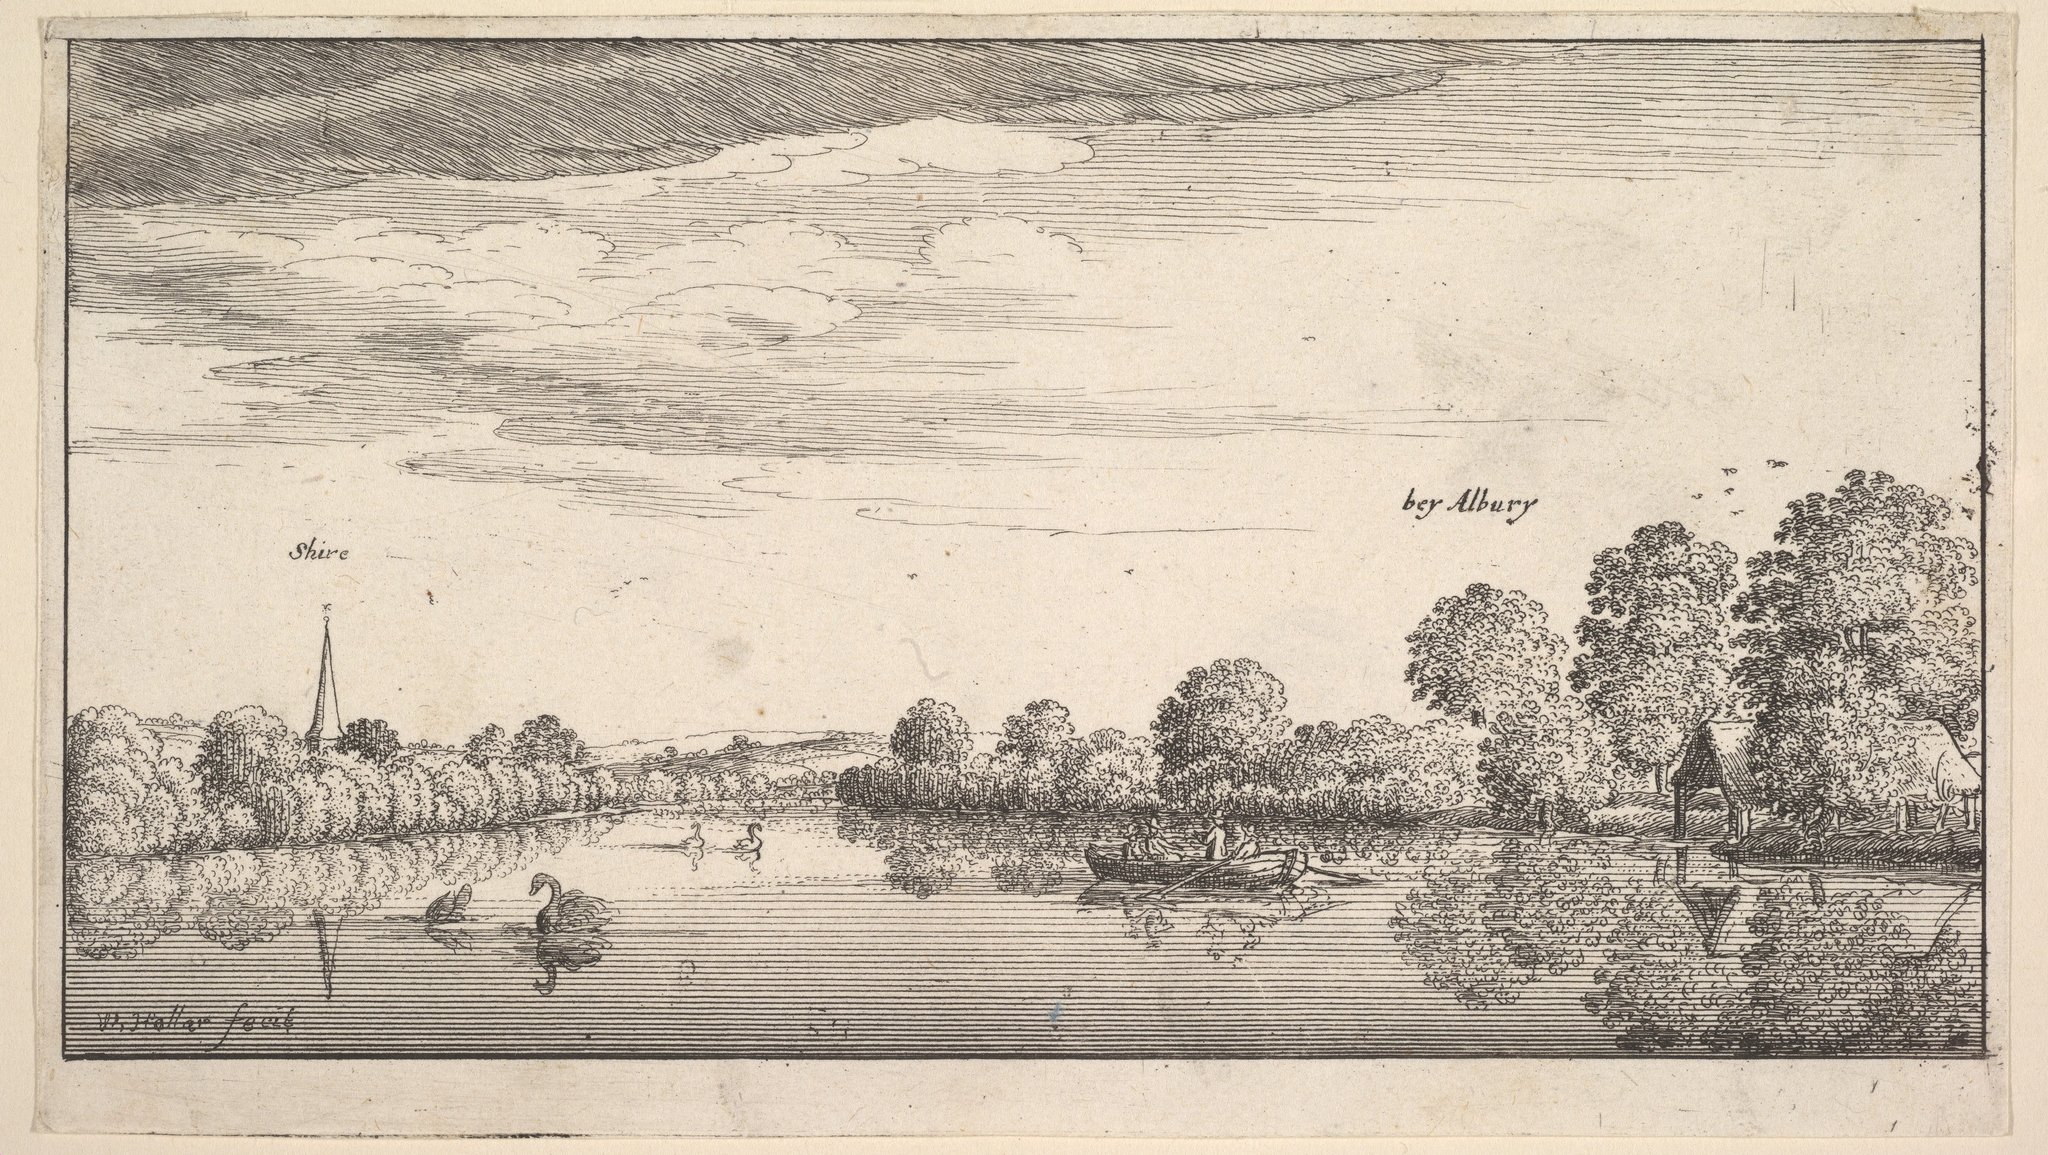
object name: print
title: View Near Albury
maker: wenceslaus hollar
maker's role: artist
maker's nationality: bohemian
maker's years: 1607-1677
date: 1645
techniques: etching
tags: human figures,swans,rivers,trees,boats